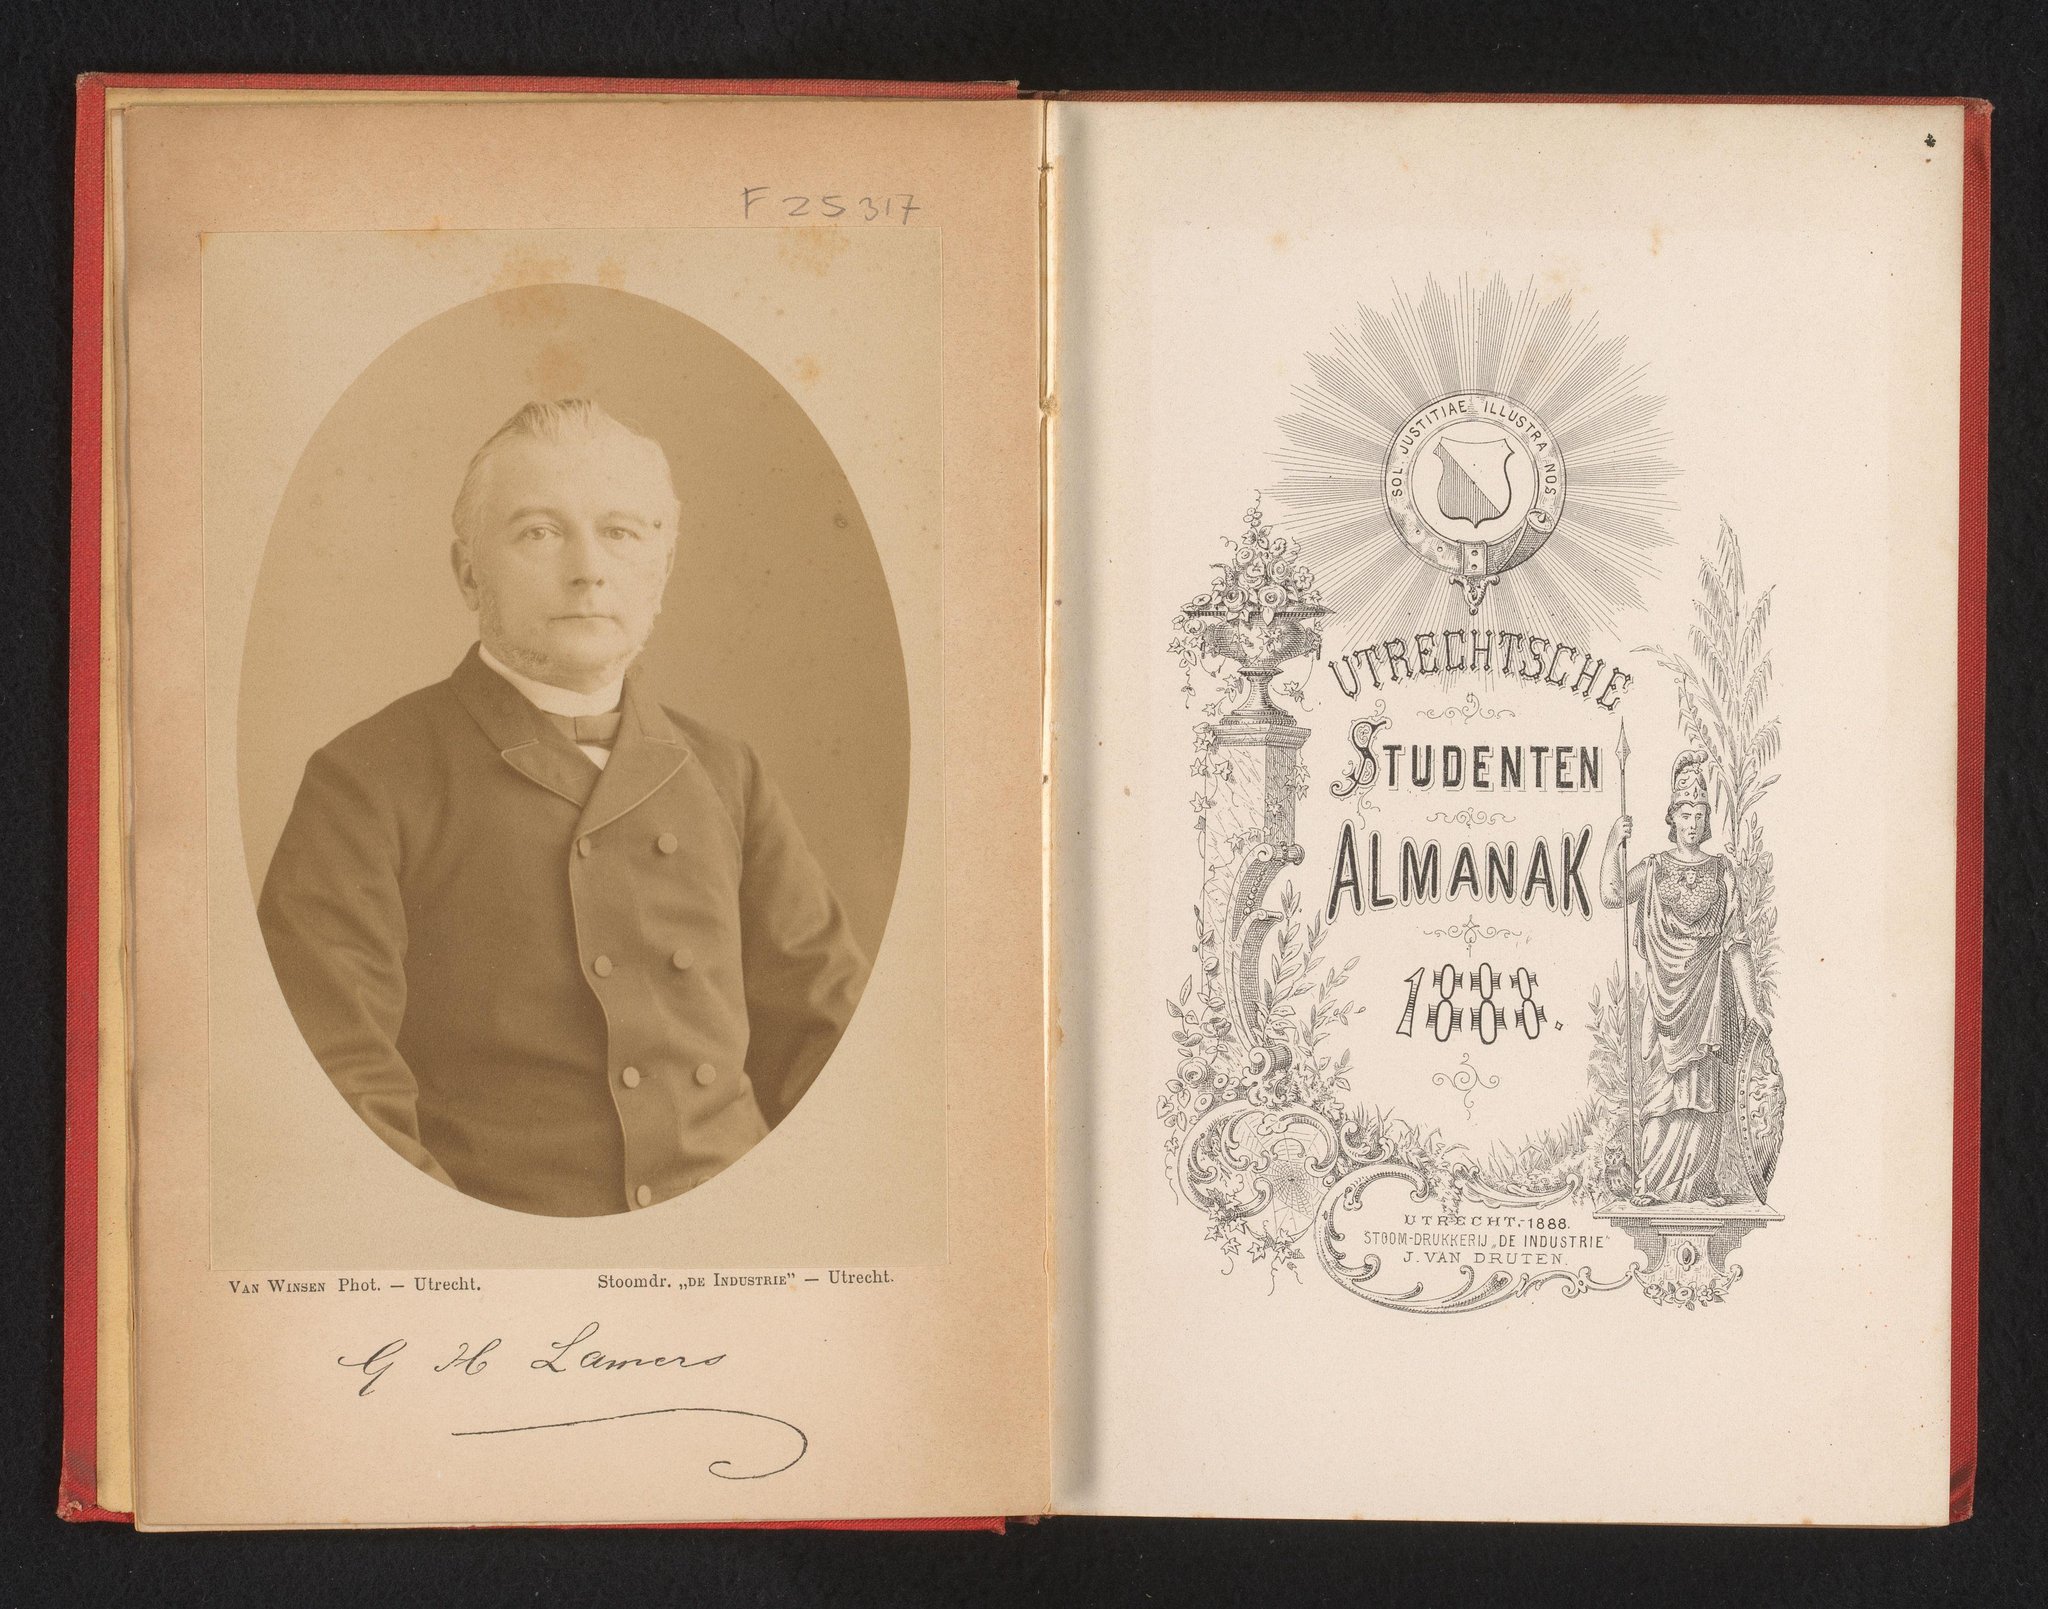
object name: photograph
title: Portret van G.H. Lamers, hoogleraar godgeleerdheid en rector magnificus van de Universiteit Utrecht 1887-1888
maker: jean jacques antoine van winsen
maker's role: fotograaf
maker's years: 1851-1927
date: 1887-1888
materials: paper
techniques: albumen print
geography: utrecht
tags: utrecht, historical persons, professor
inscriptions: signature: ‘G H Lamers’